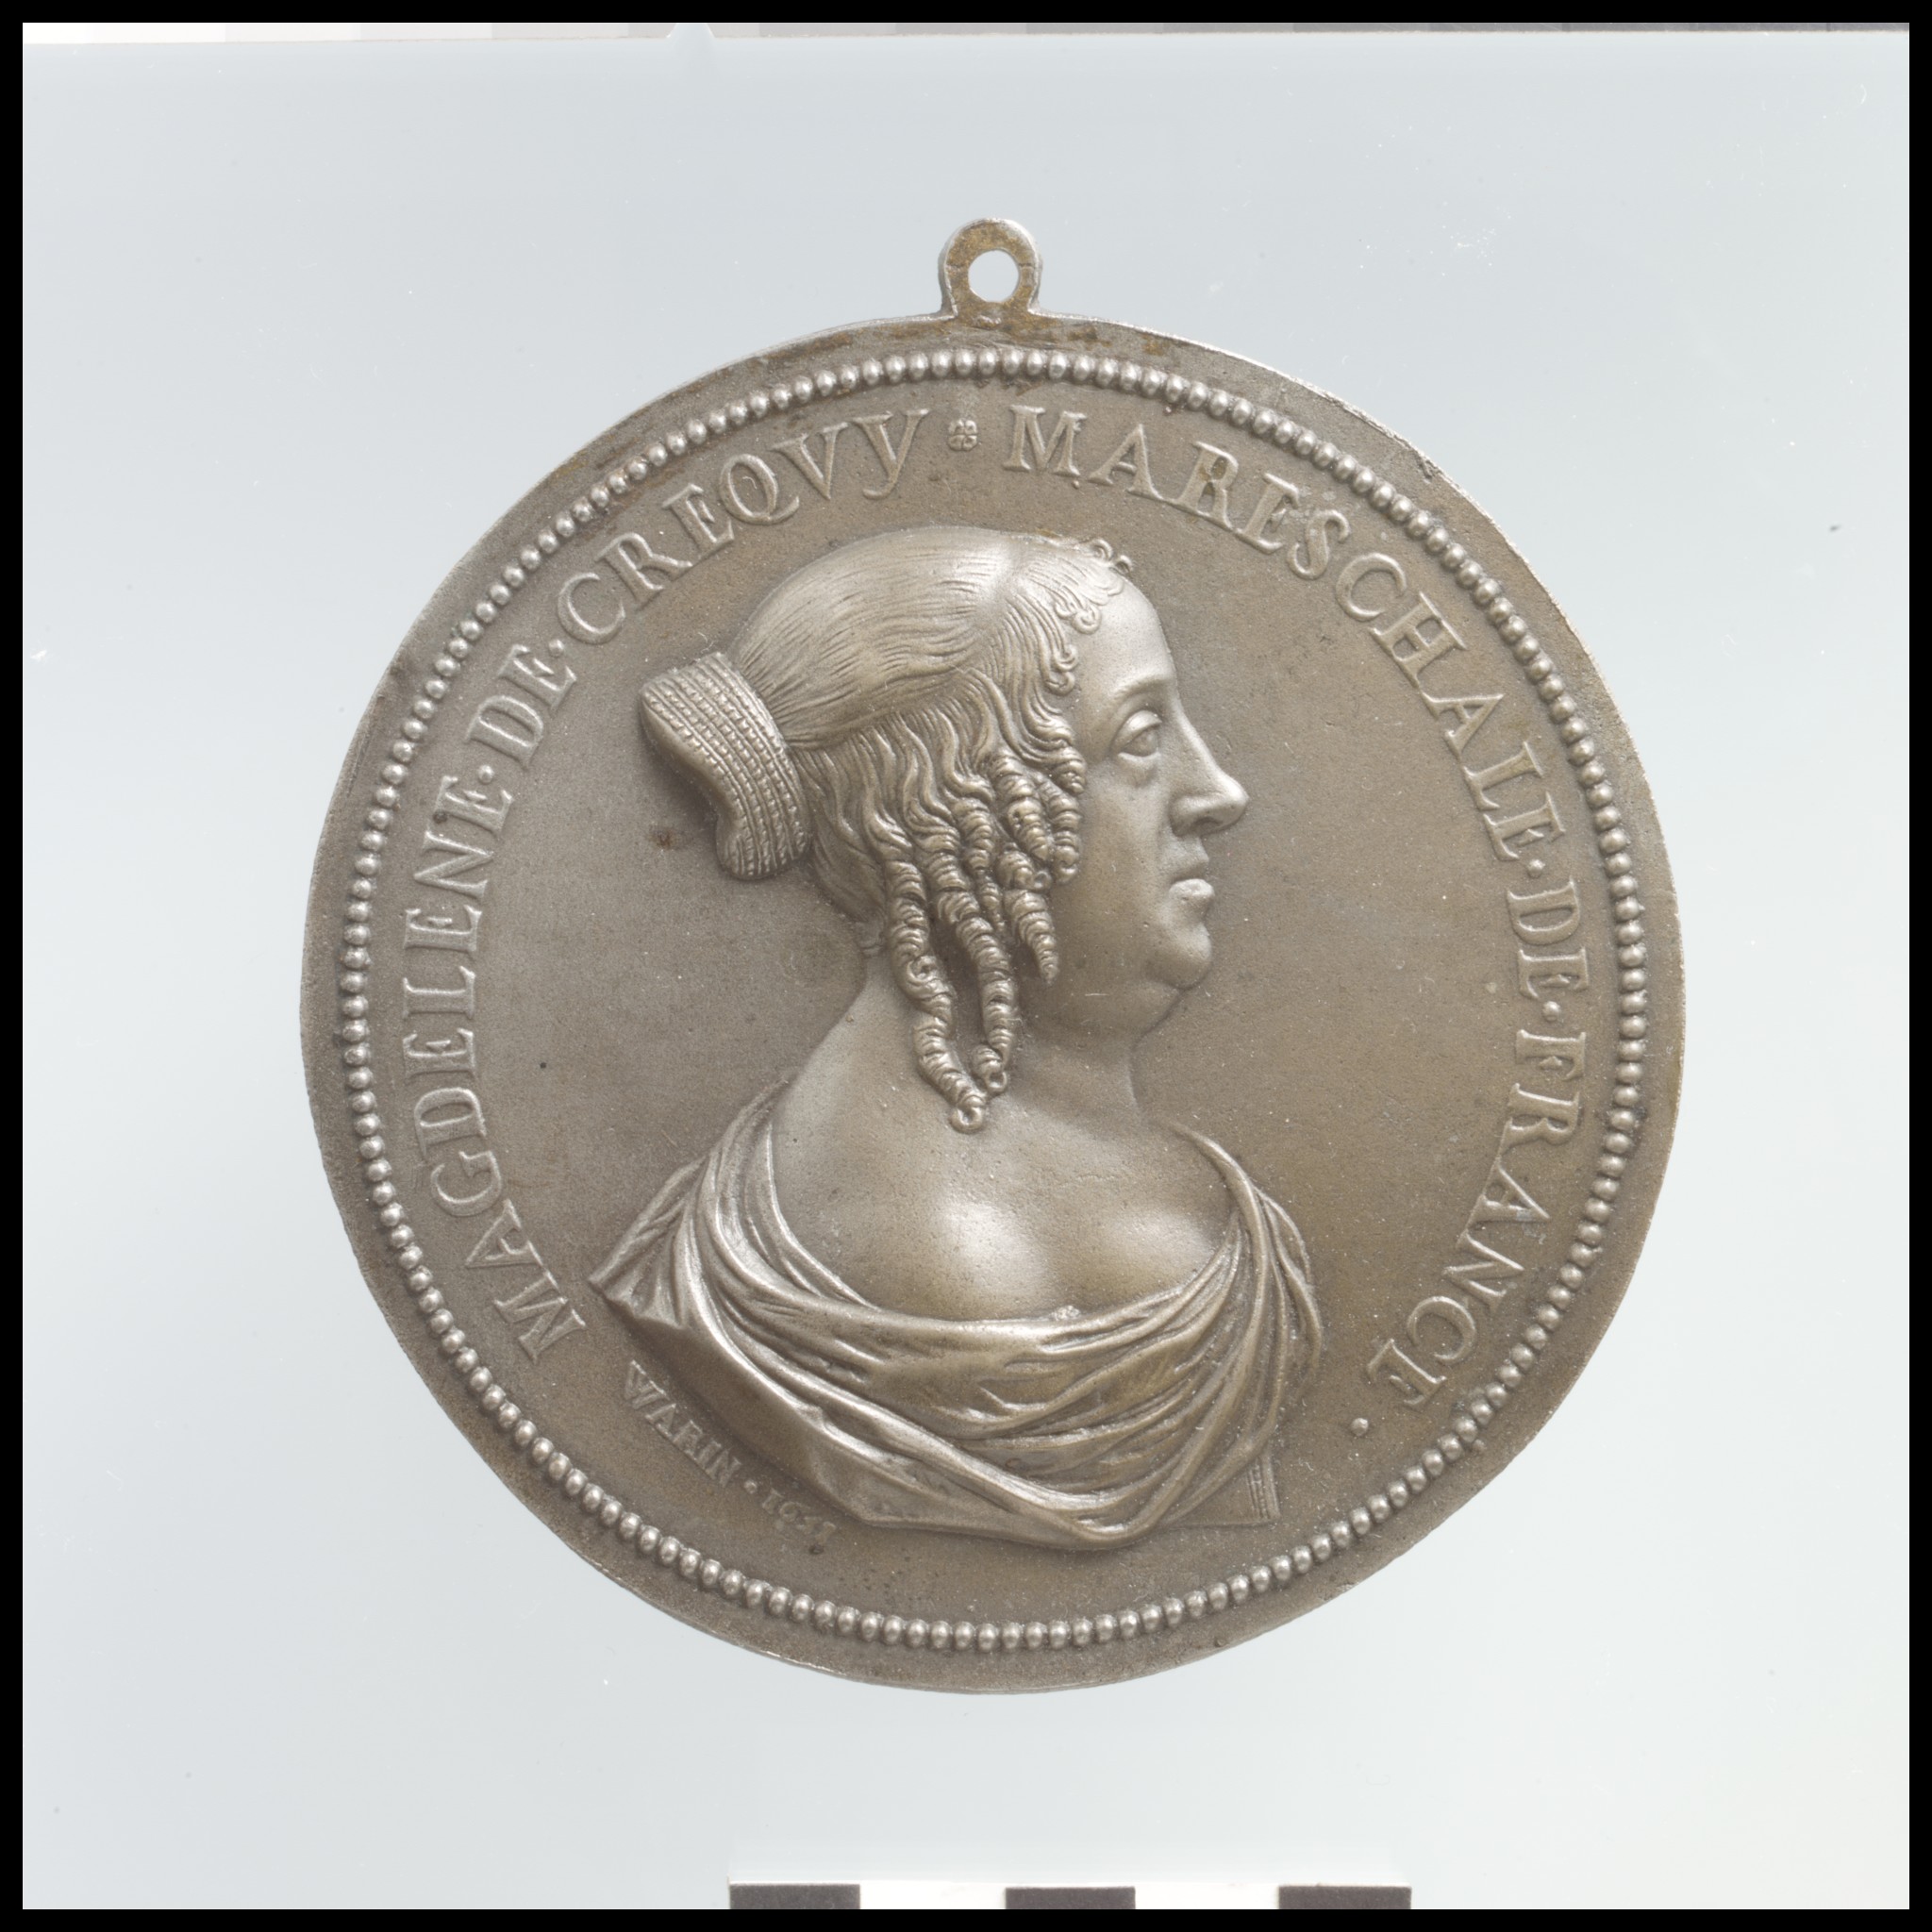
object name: medal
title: Madeleine de Créquy, Maréchale de Villeroy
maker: claude varin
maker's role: artist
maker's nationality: french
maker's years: 1630-1654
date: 1651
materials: bronze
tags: profiles,women